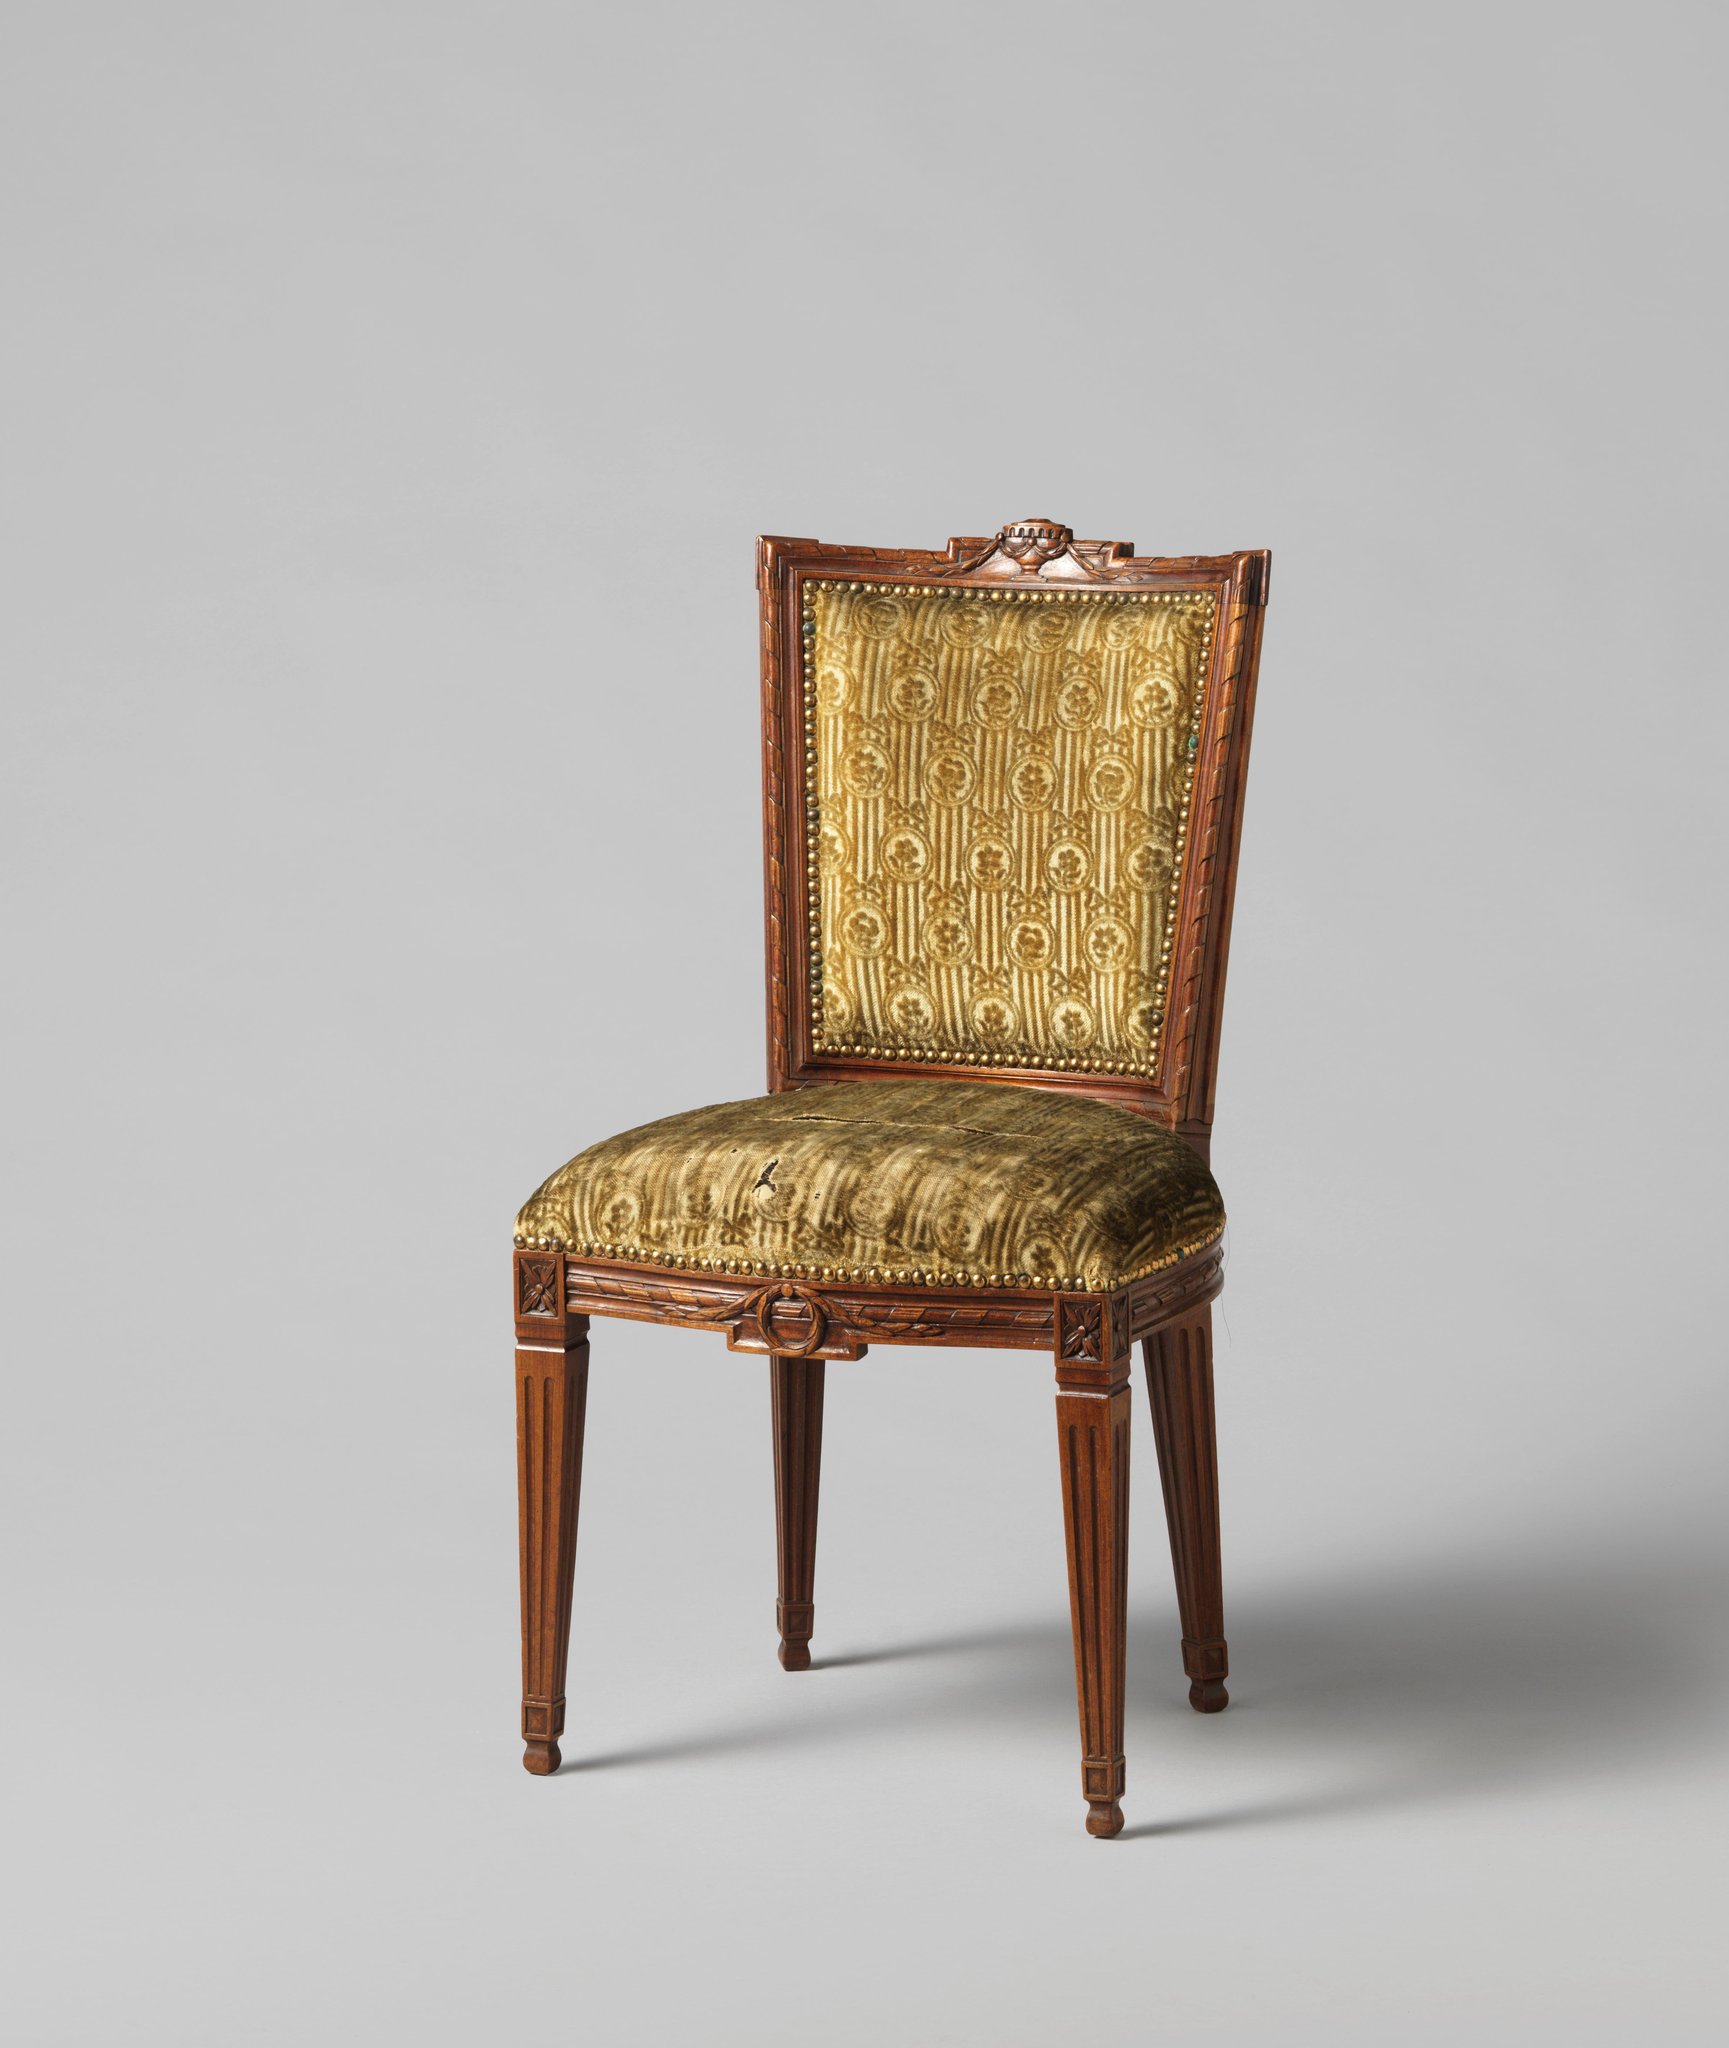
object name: seating furniture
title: Stoel van mahoniehout, bekleed met trijp met een doorlopend patroon van aan strikken hangende ovalen waarin een bloem op gestreepte grond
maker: Anonymous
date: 1775-1800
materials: wood, textile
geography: northern netherlands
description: Chair. Mahogany, with the original upholstery of moquette (trijp). Netherlands, c. 1780 - 1800. Mr and Mrs Drucker-Fraser bequest, 1949.